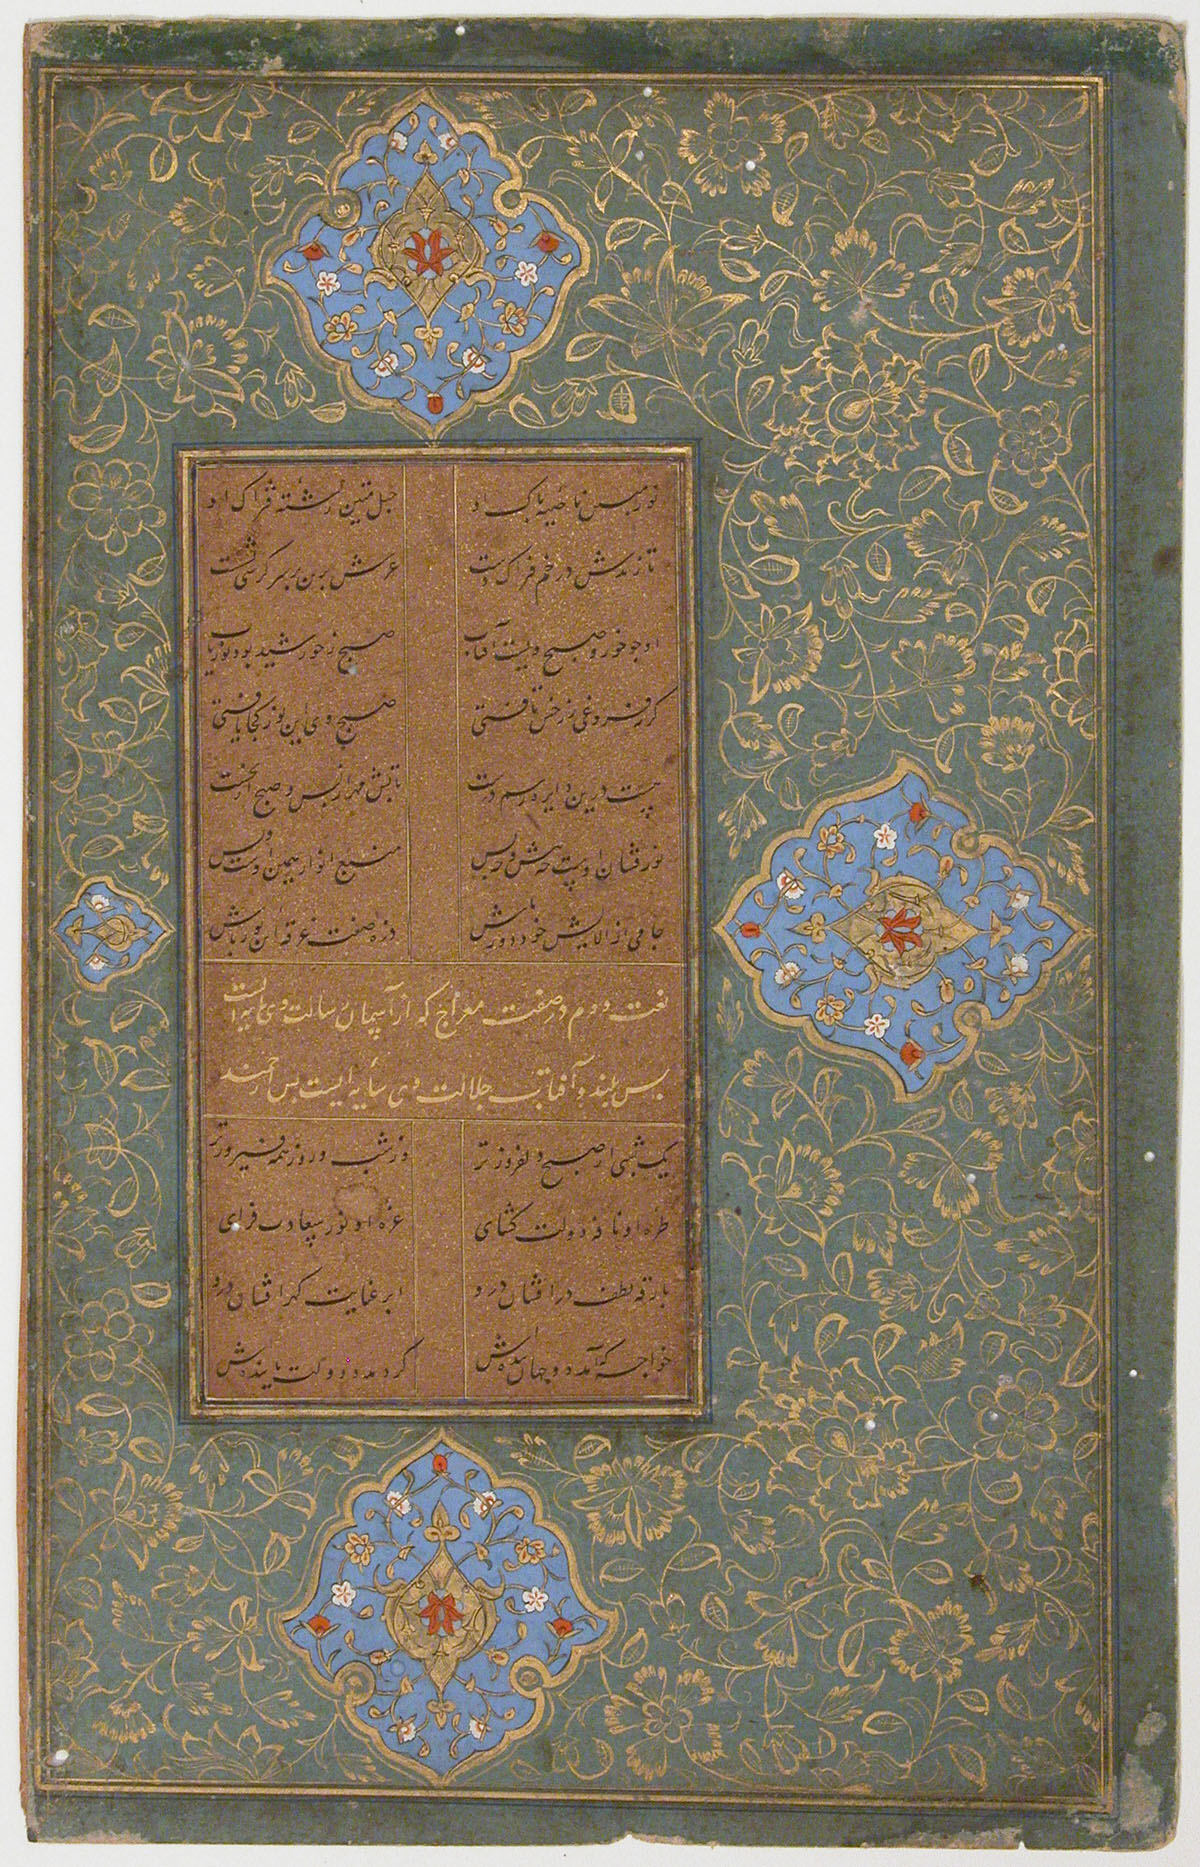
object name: folio from a non illustrated manuscript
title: Tuhfat al-Ahrar (The Gift to the Noble)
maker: maulana nur al-din `abd al-rahman jami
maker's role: author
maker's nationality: iranian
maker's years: 1414-1492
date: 1485-1490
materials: gold, ink, paper, watercolor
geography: afghanistan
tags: flowers,calligraphy